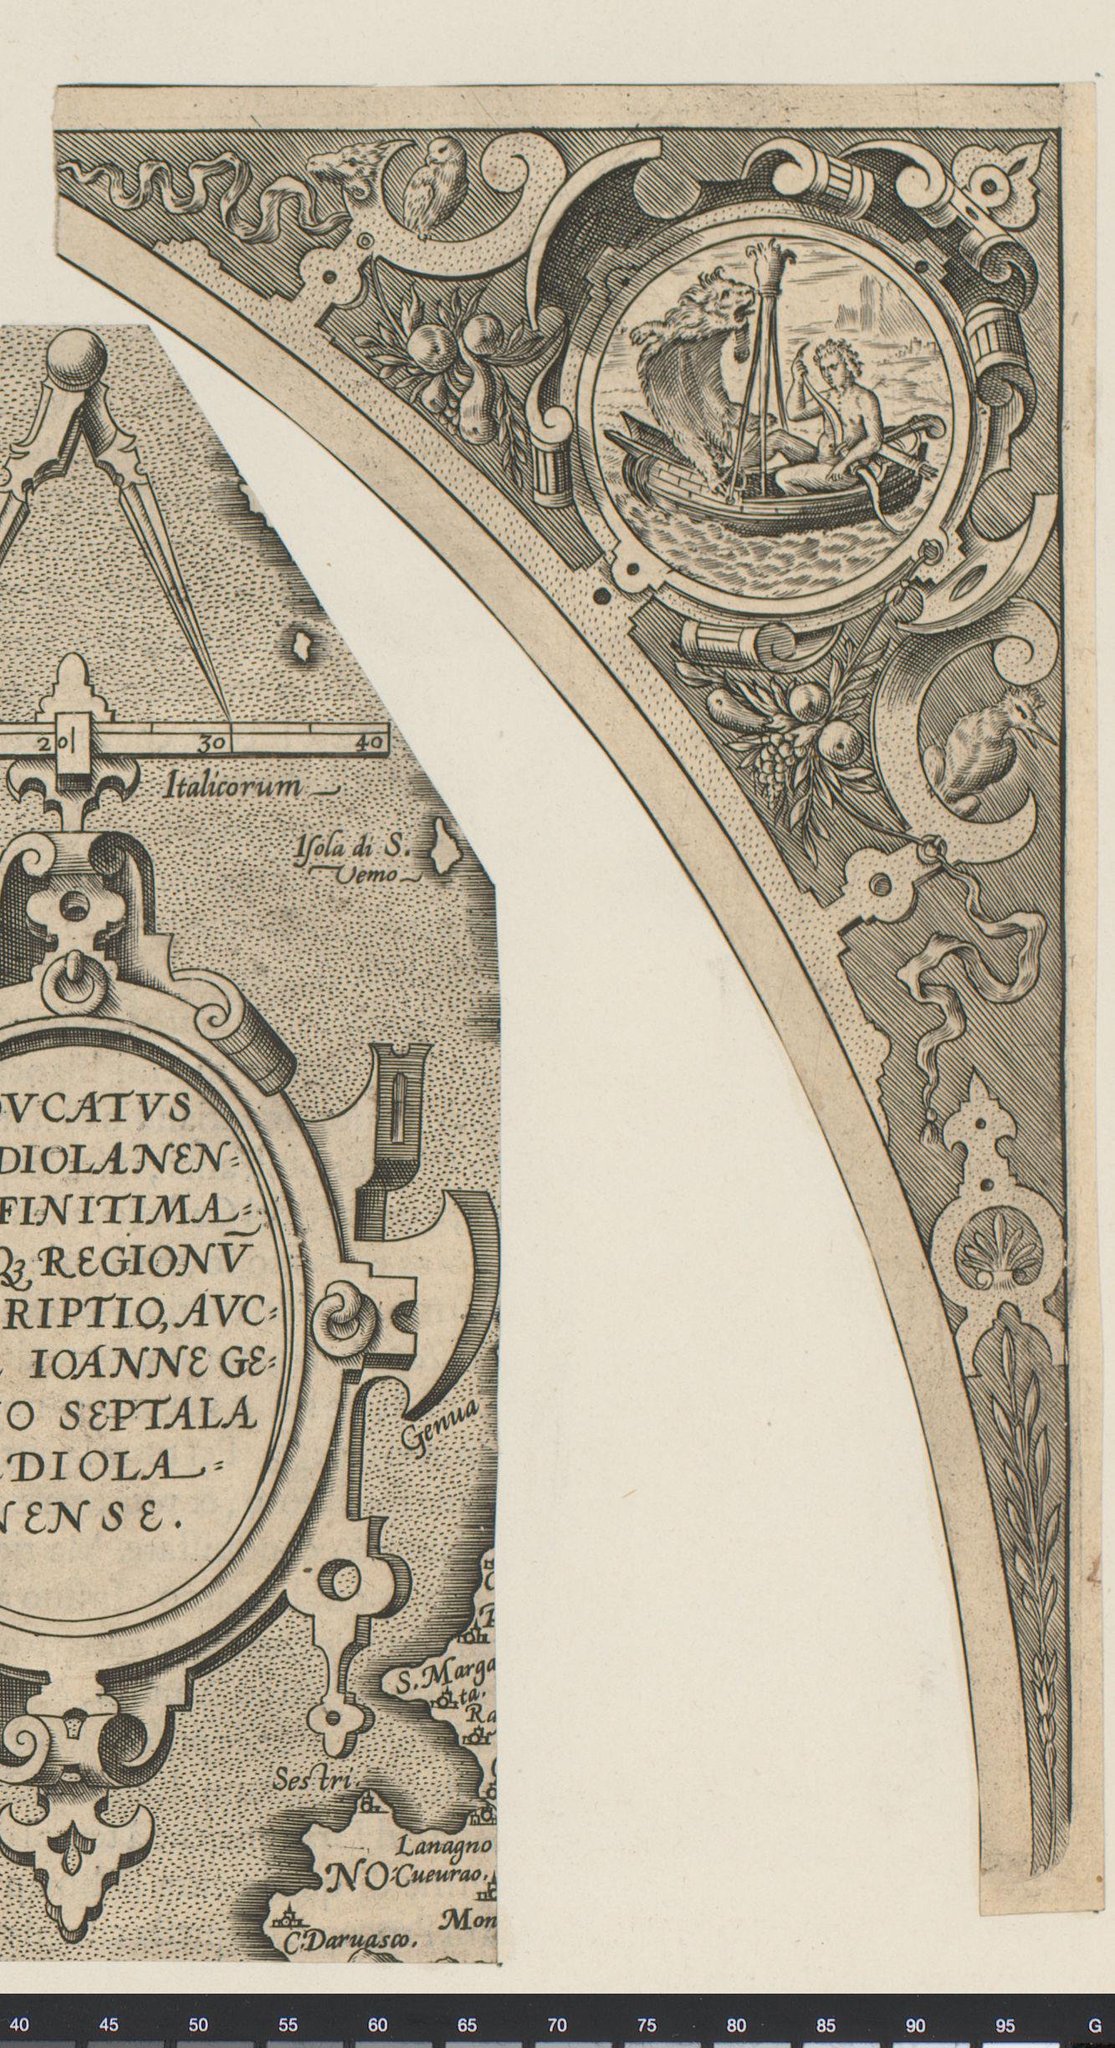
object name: album leaf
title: Carpetaniae Partis Descr / Guipuscoae Regionis Typus / Hanc Insulam Perustrabat (...)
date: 1584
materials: paper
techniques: engraving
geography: antwerp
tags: (story of) hercules (heracles), ornaments ~ art, fruits and vegetables ~ ornament, birds, ornament ~ cartouche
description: Hoekornament met trossen fruit en vogels. Daarbij een rolwerkcartouche met Hercules in een boot. Het ornament is een fragment van een kaart van Carpetania, Gipuzkoa en Cadiz. De prent maakt deel uit van een album.